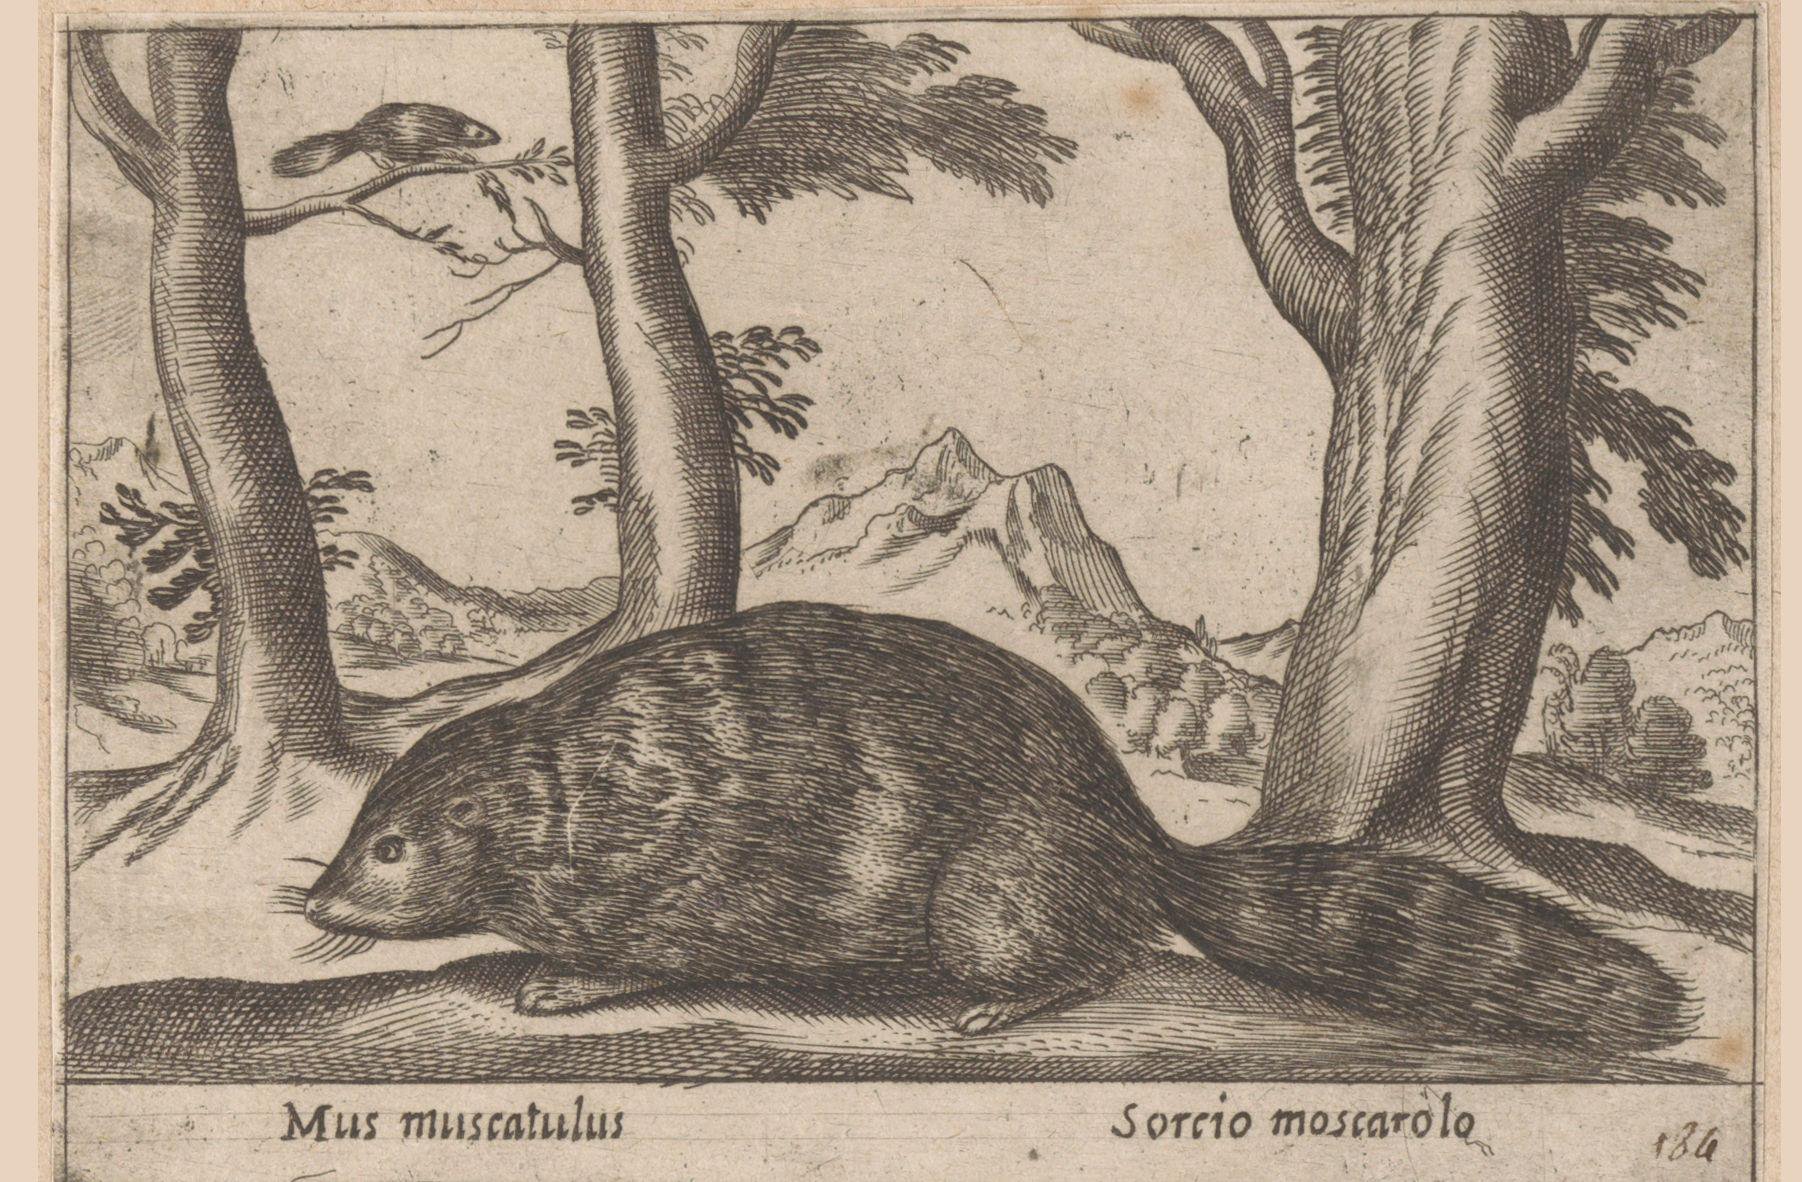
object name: print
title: Dieren en fabelwezens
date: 1565-1630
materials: paper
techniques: etching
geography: rome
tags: rodents: musk-rat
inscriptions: number: ‘184’, collector's mark: Lugt 11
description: Deze prent maakt deel uit van een reeks prenten van dieren door Antonio Tempesta. Bekend is dat een tweede staat (met nummering) van deze serie is uitgegeven door Giovanni Giacomo de' Rossi in 1650. Onbekend is wie de eerste staat heeft uitgegeven en wanneer.